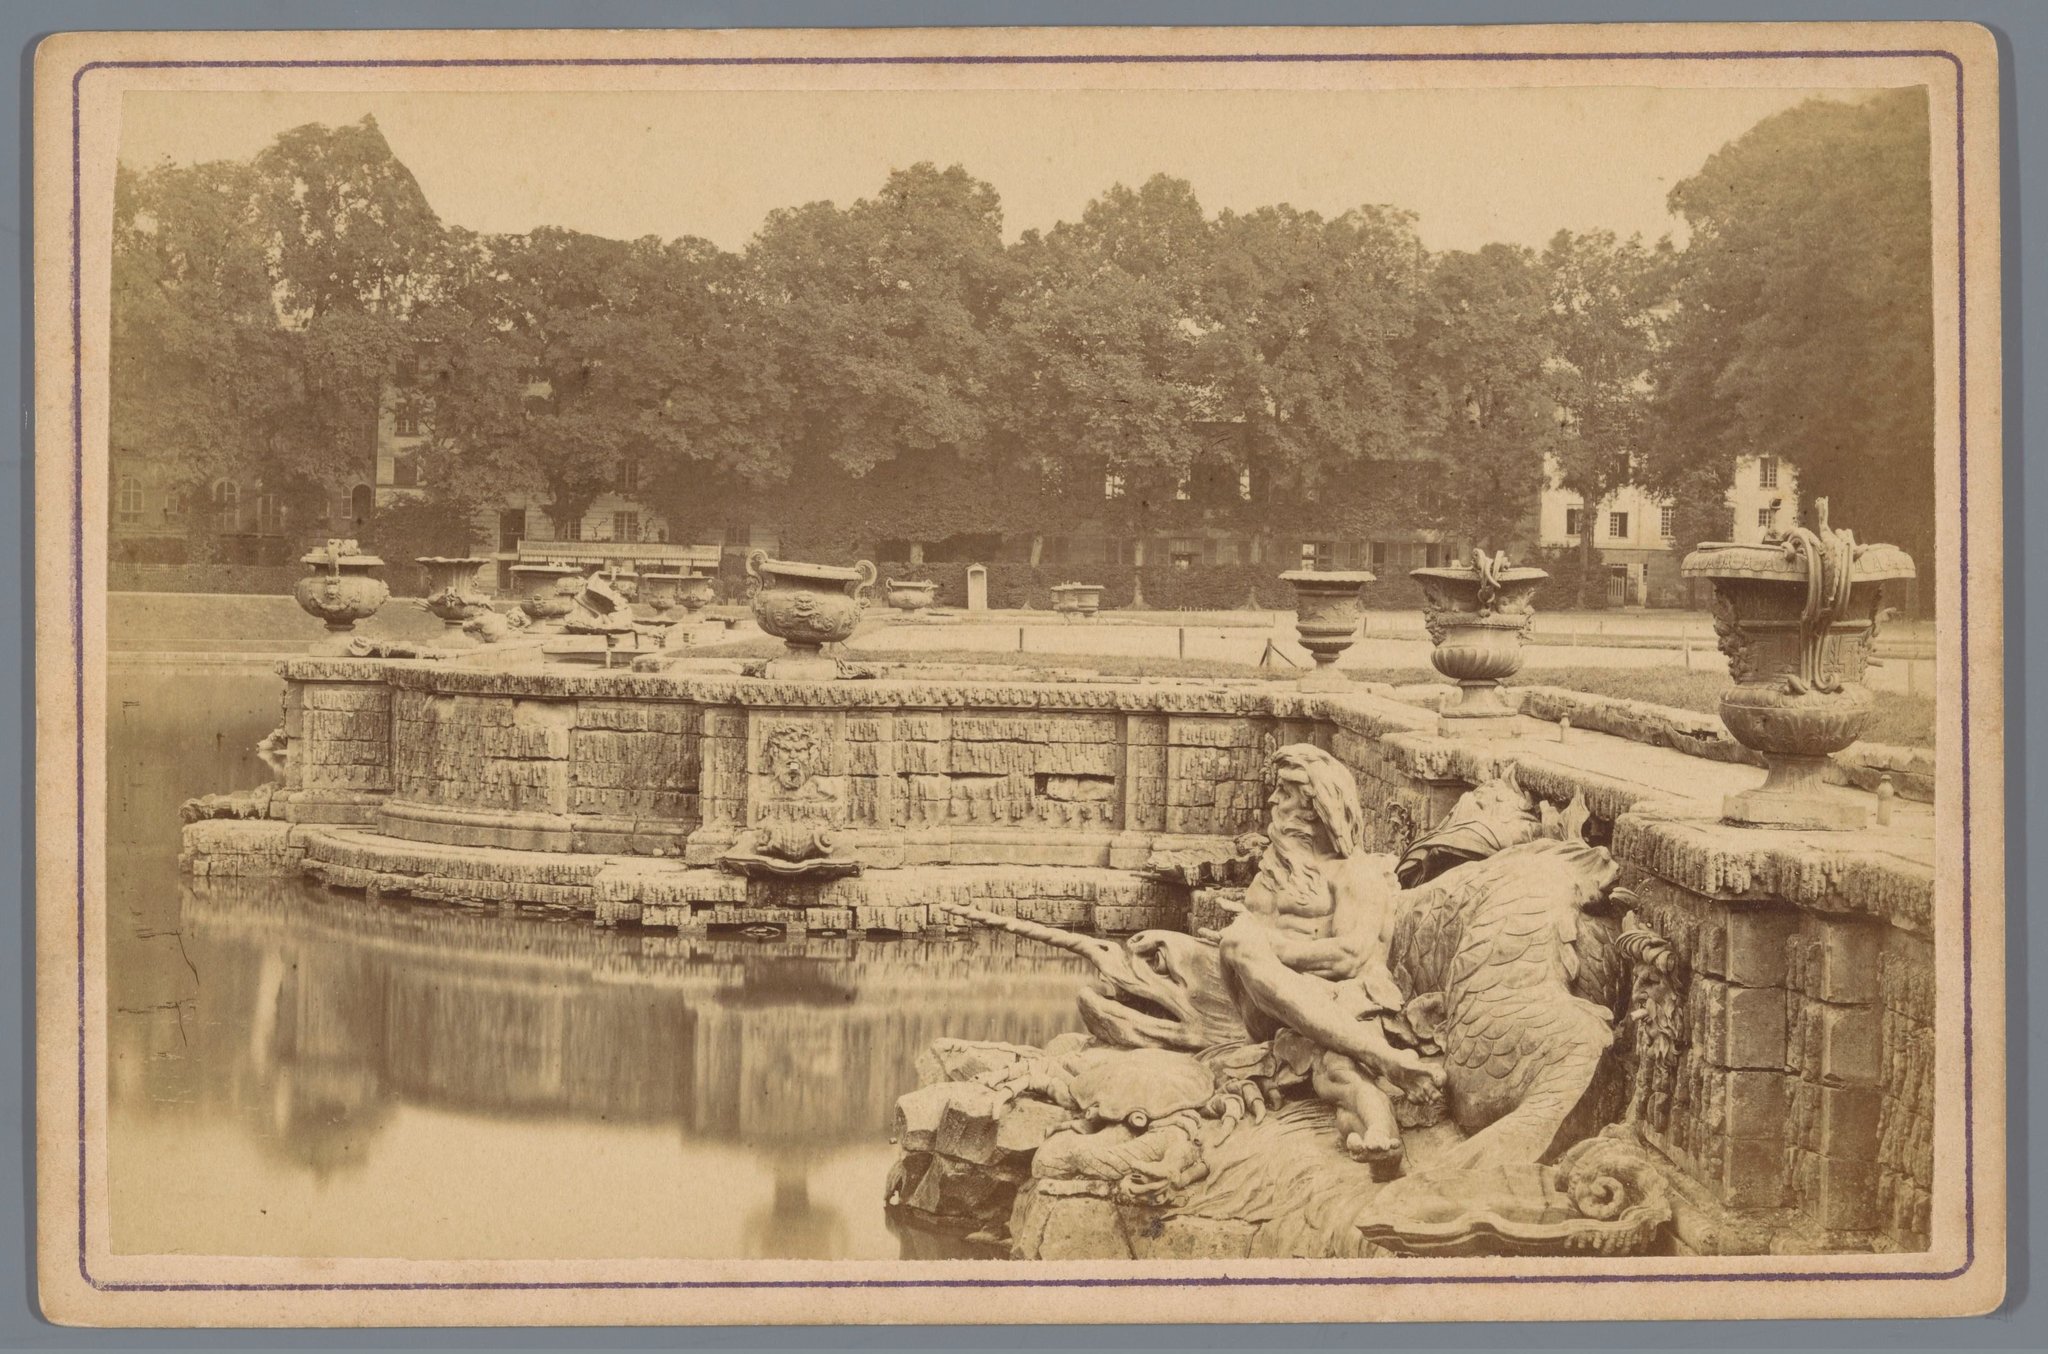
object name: cabinet photograph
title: Neptunusvijver in de Tuin van Versailles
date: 1865-1875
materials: cardboard, photographic support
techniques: albumen print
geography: gardens of versailles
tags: pond, pool, ornamental fountain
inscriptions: inscription: ‘Bassin de Neptune a Versailles’, inscription: ‘Compagnie Photographique Debitte & Hervé 170, Rue de Rivoli, Paris’